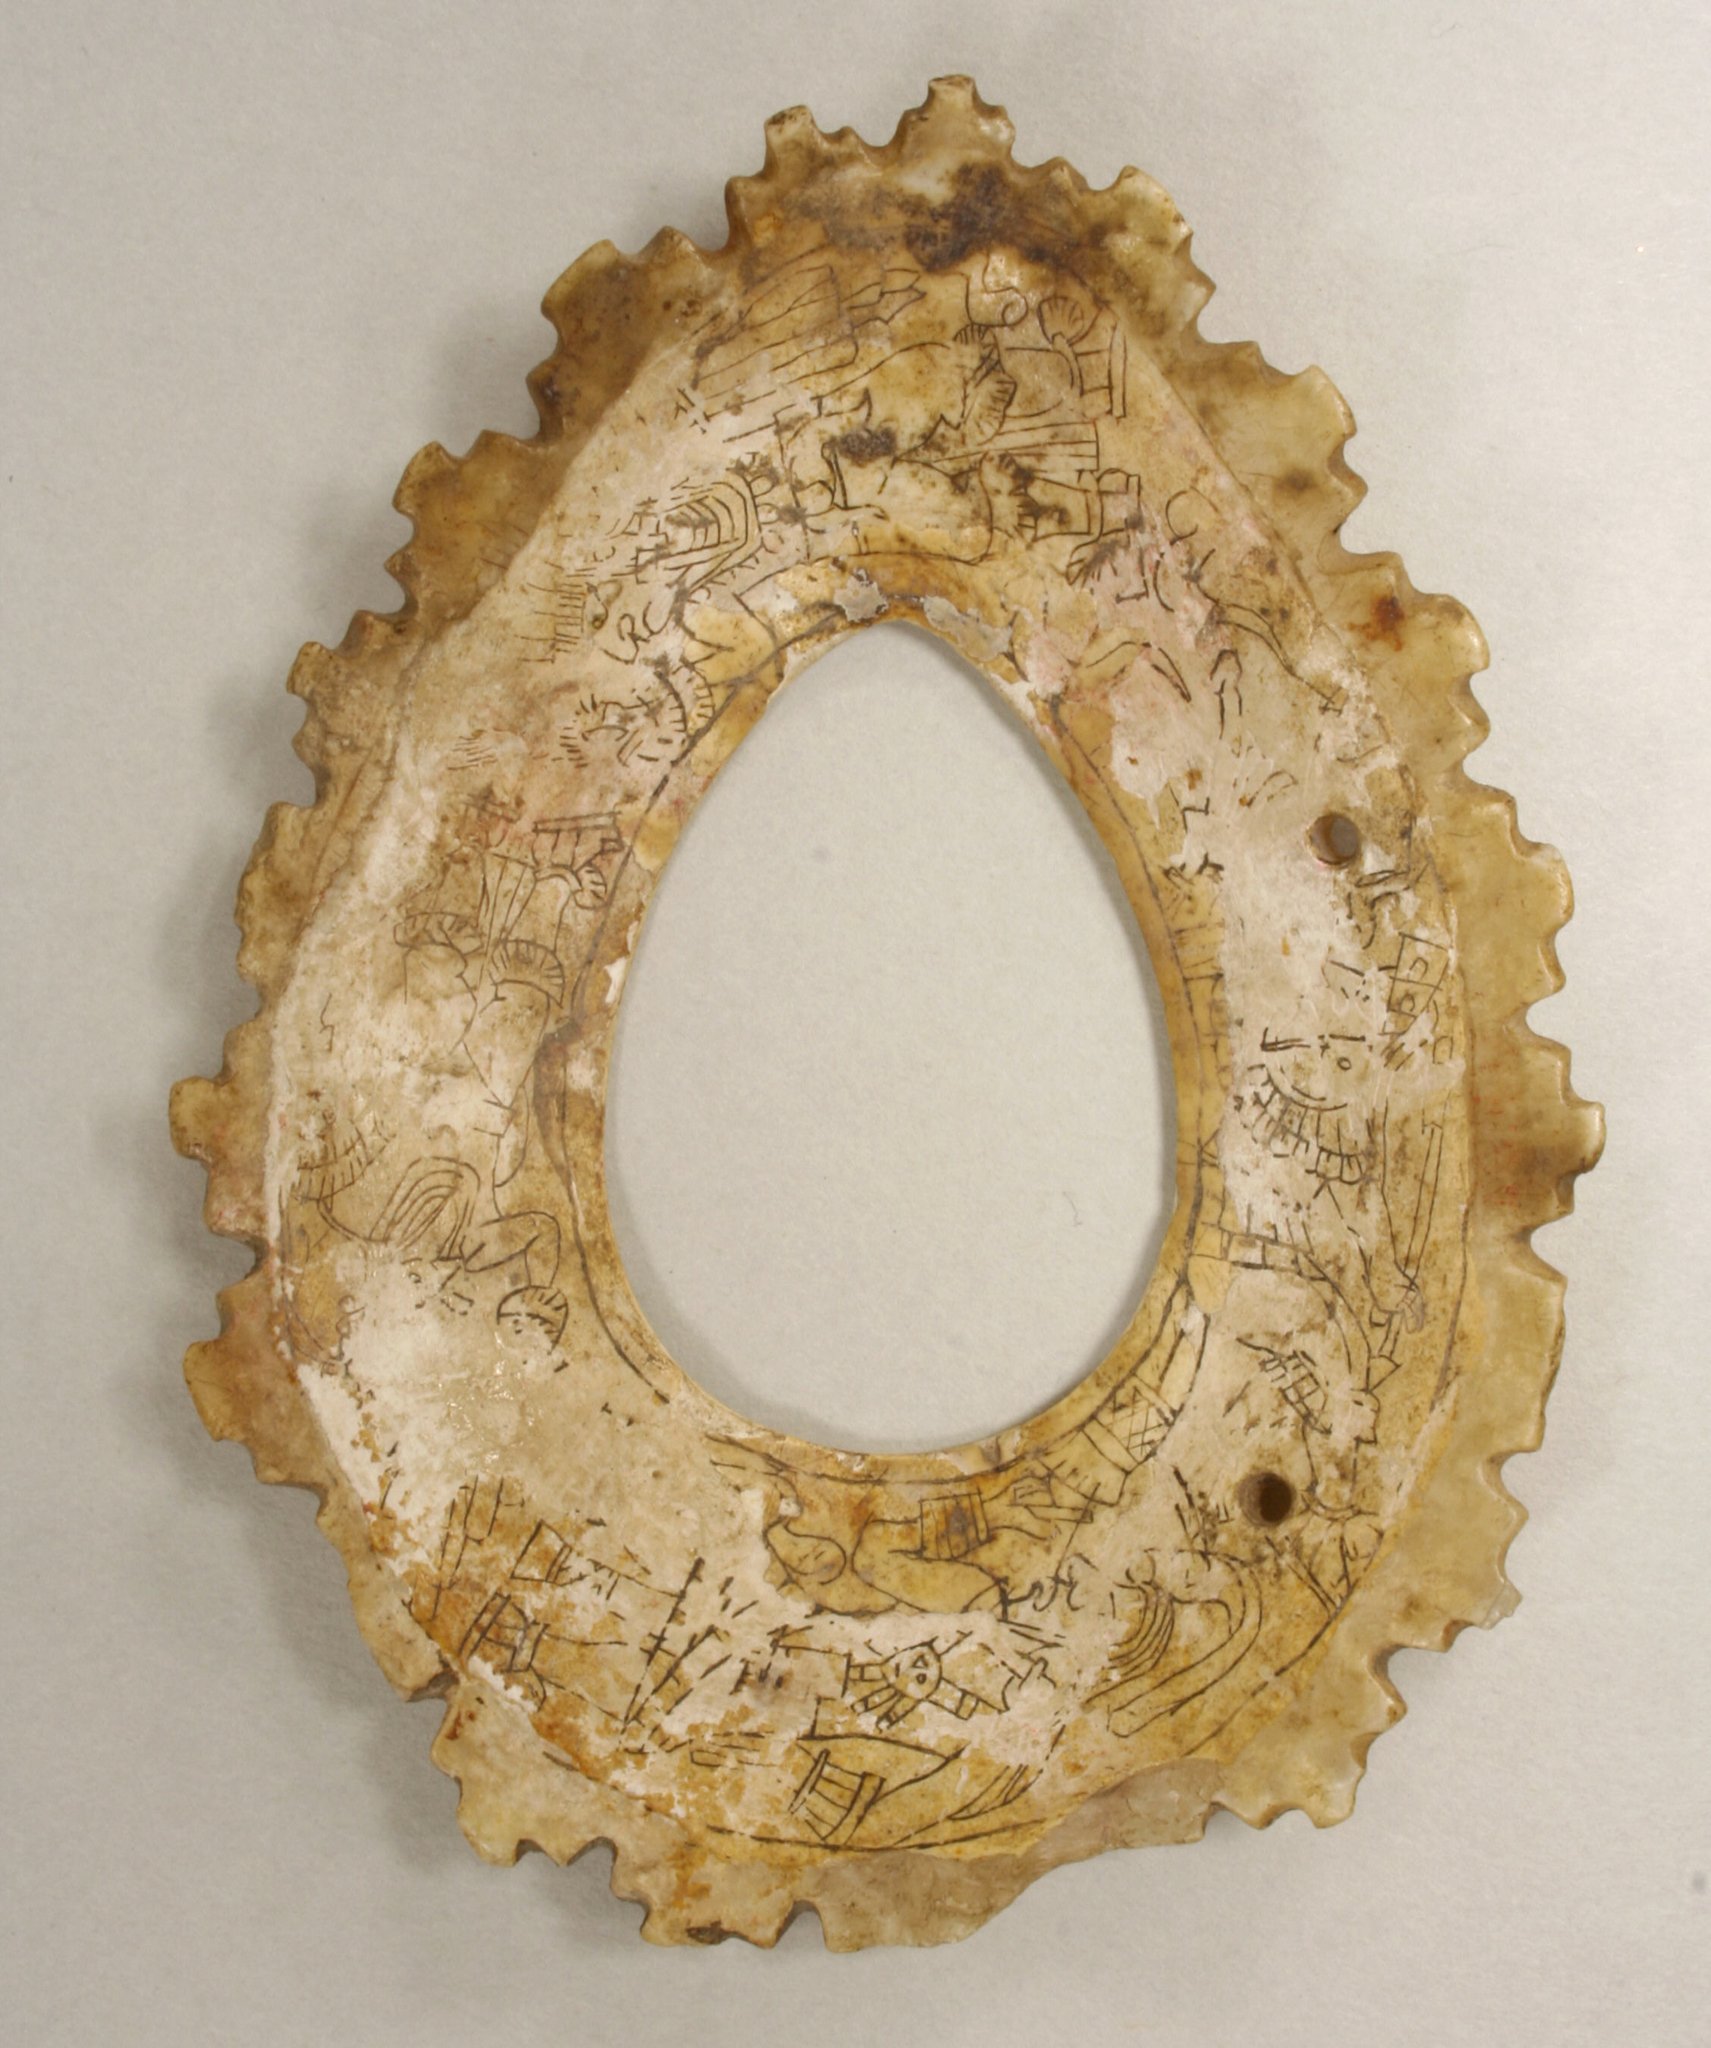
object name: pendant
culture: toltec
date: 901-1300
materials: shell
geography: mexico